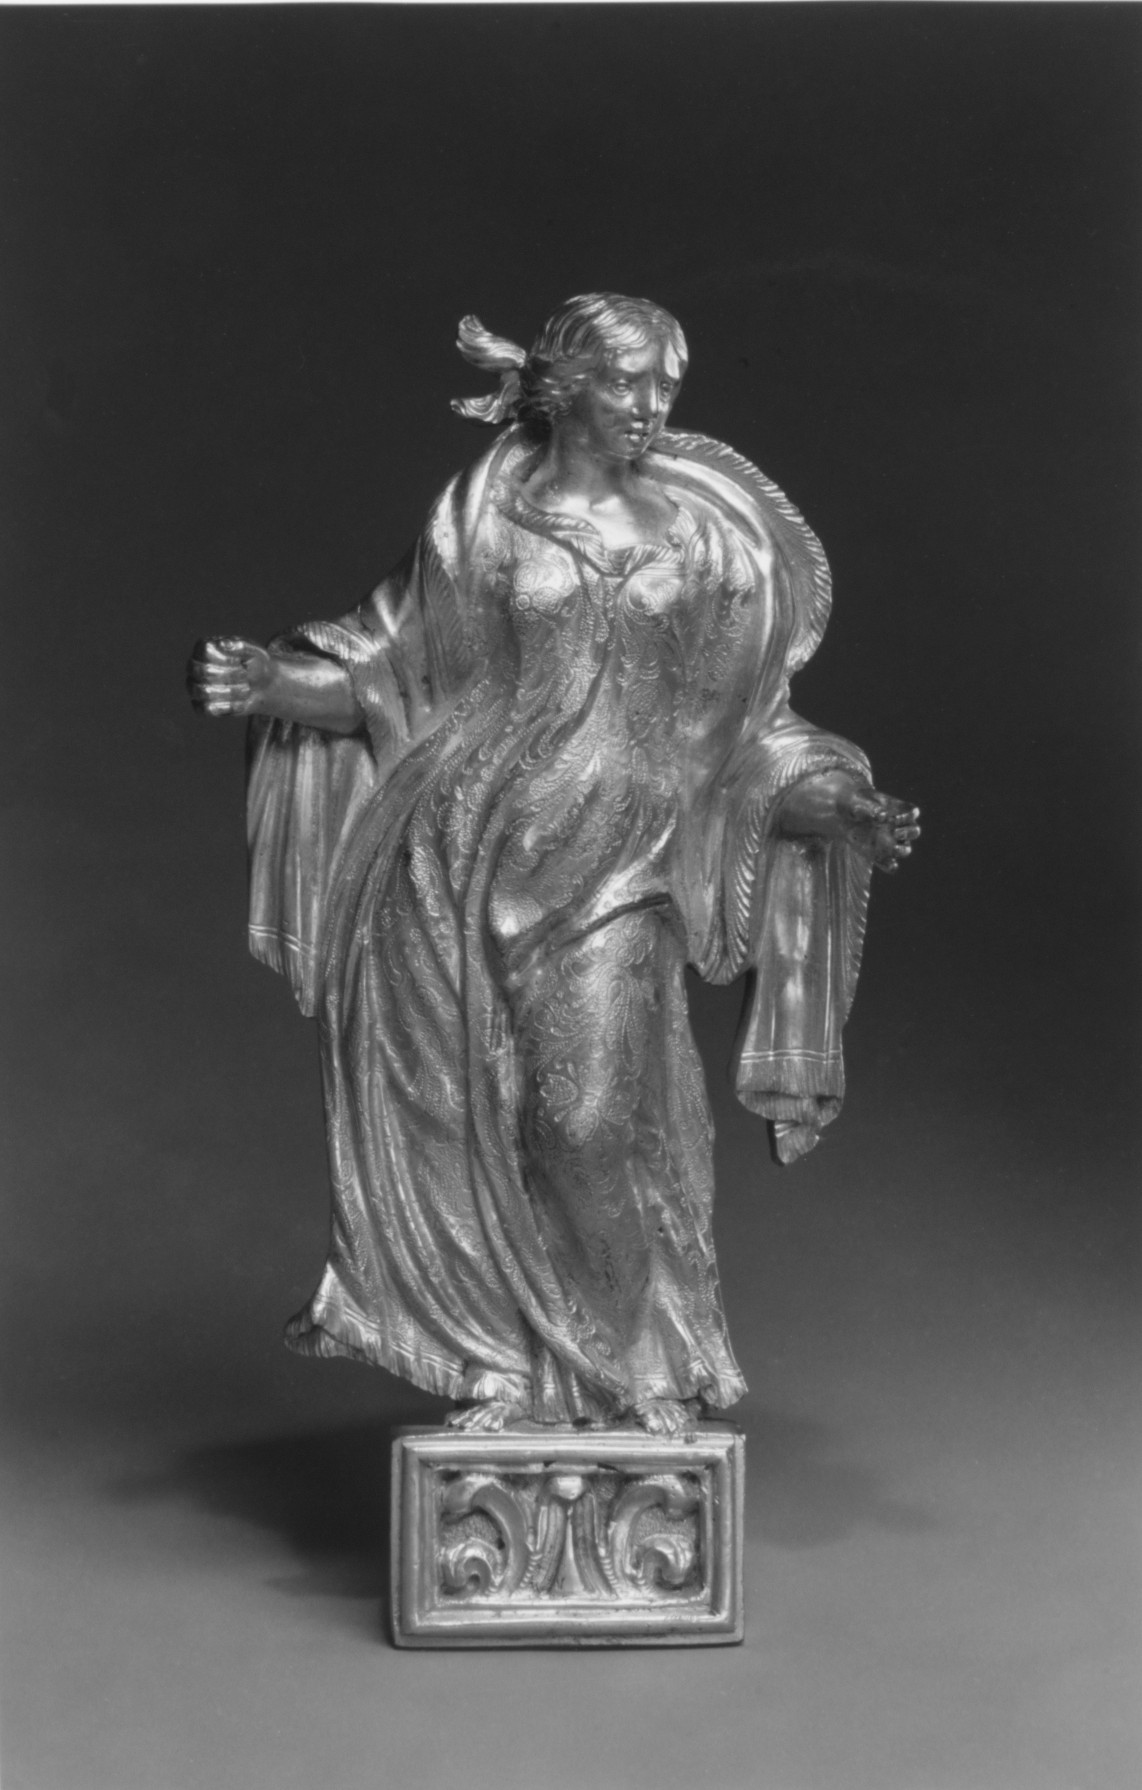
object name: plaquette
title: Female saint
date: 1601-1800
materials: gilt bronze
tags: women,saints